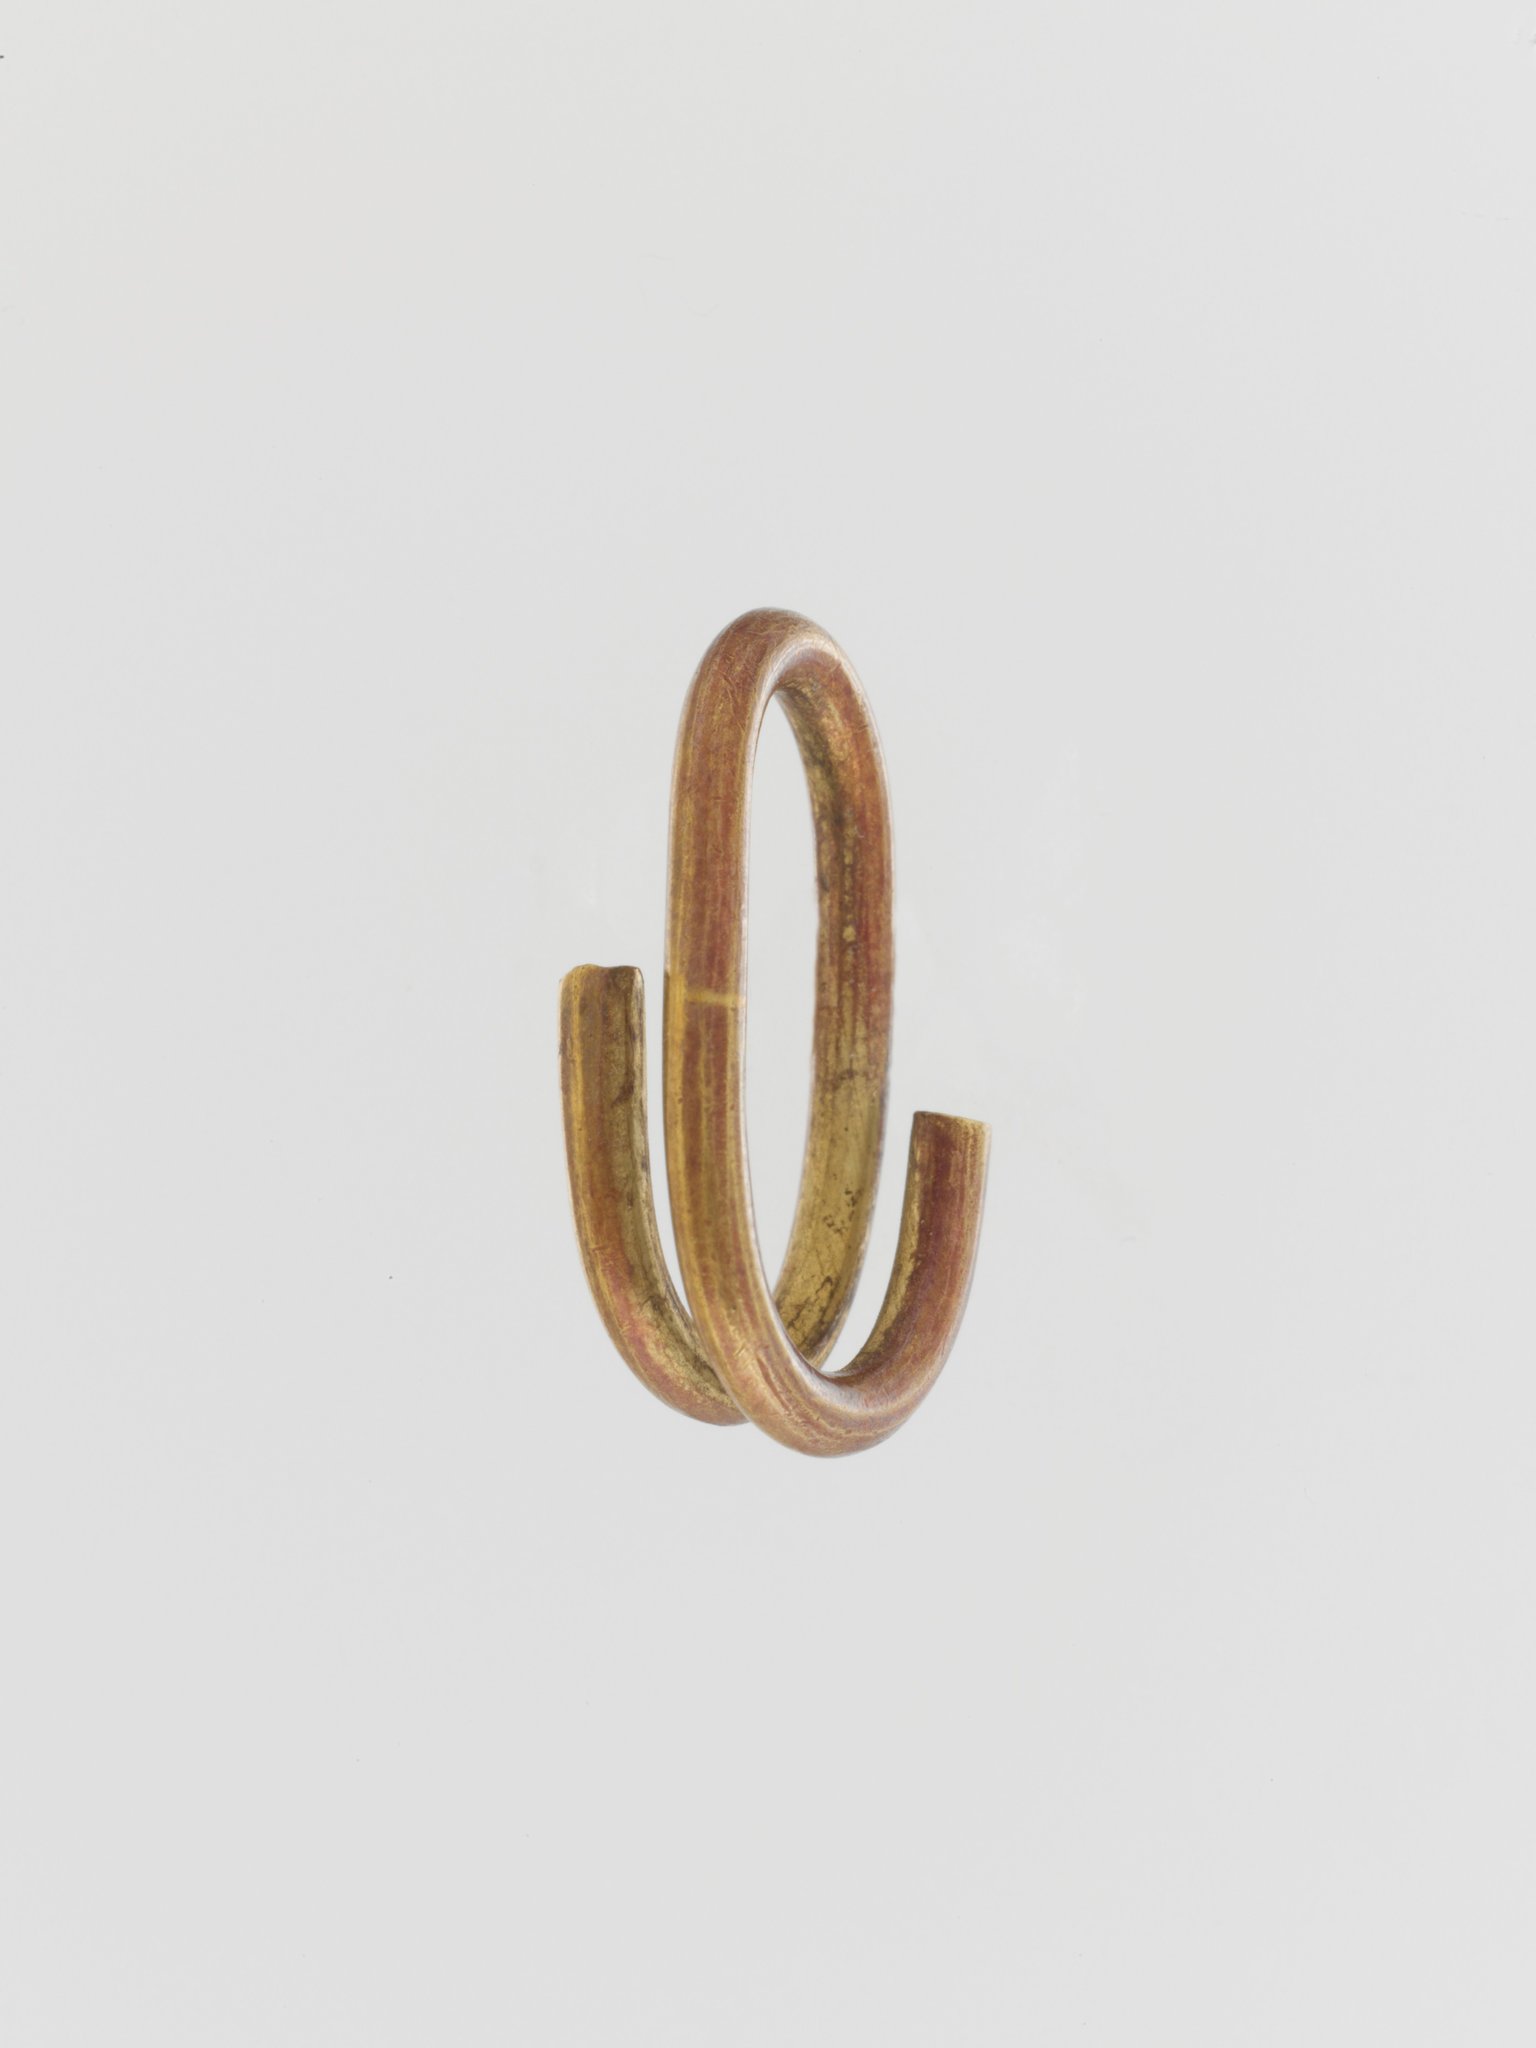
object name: earring or spiral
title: Gold spiral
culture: cypriot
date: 1600-1100 BCE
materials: gold